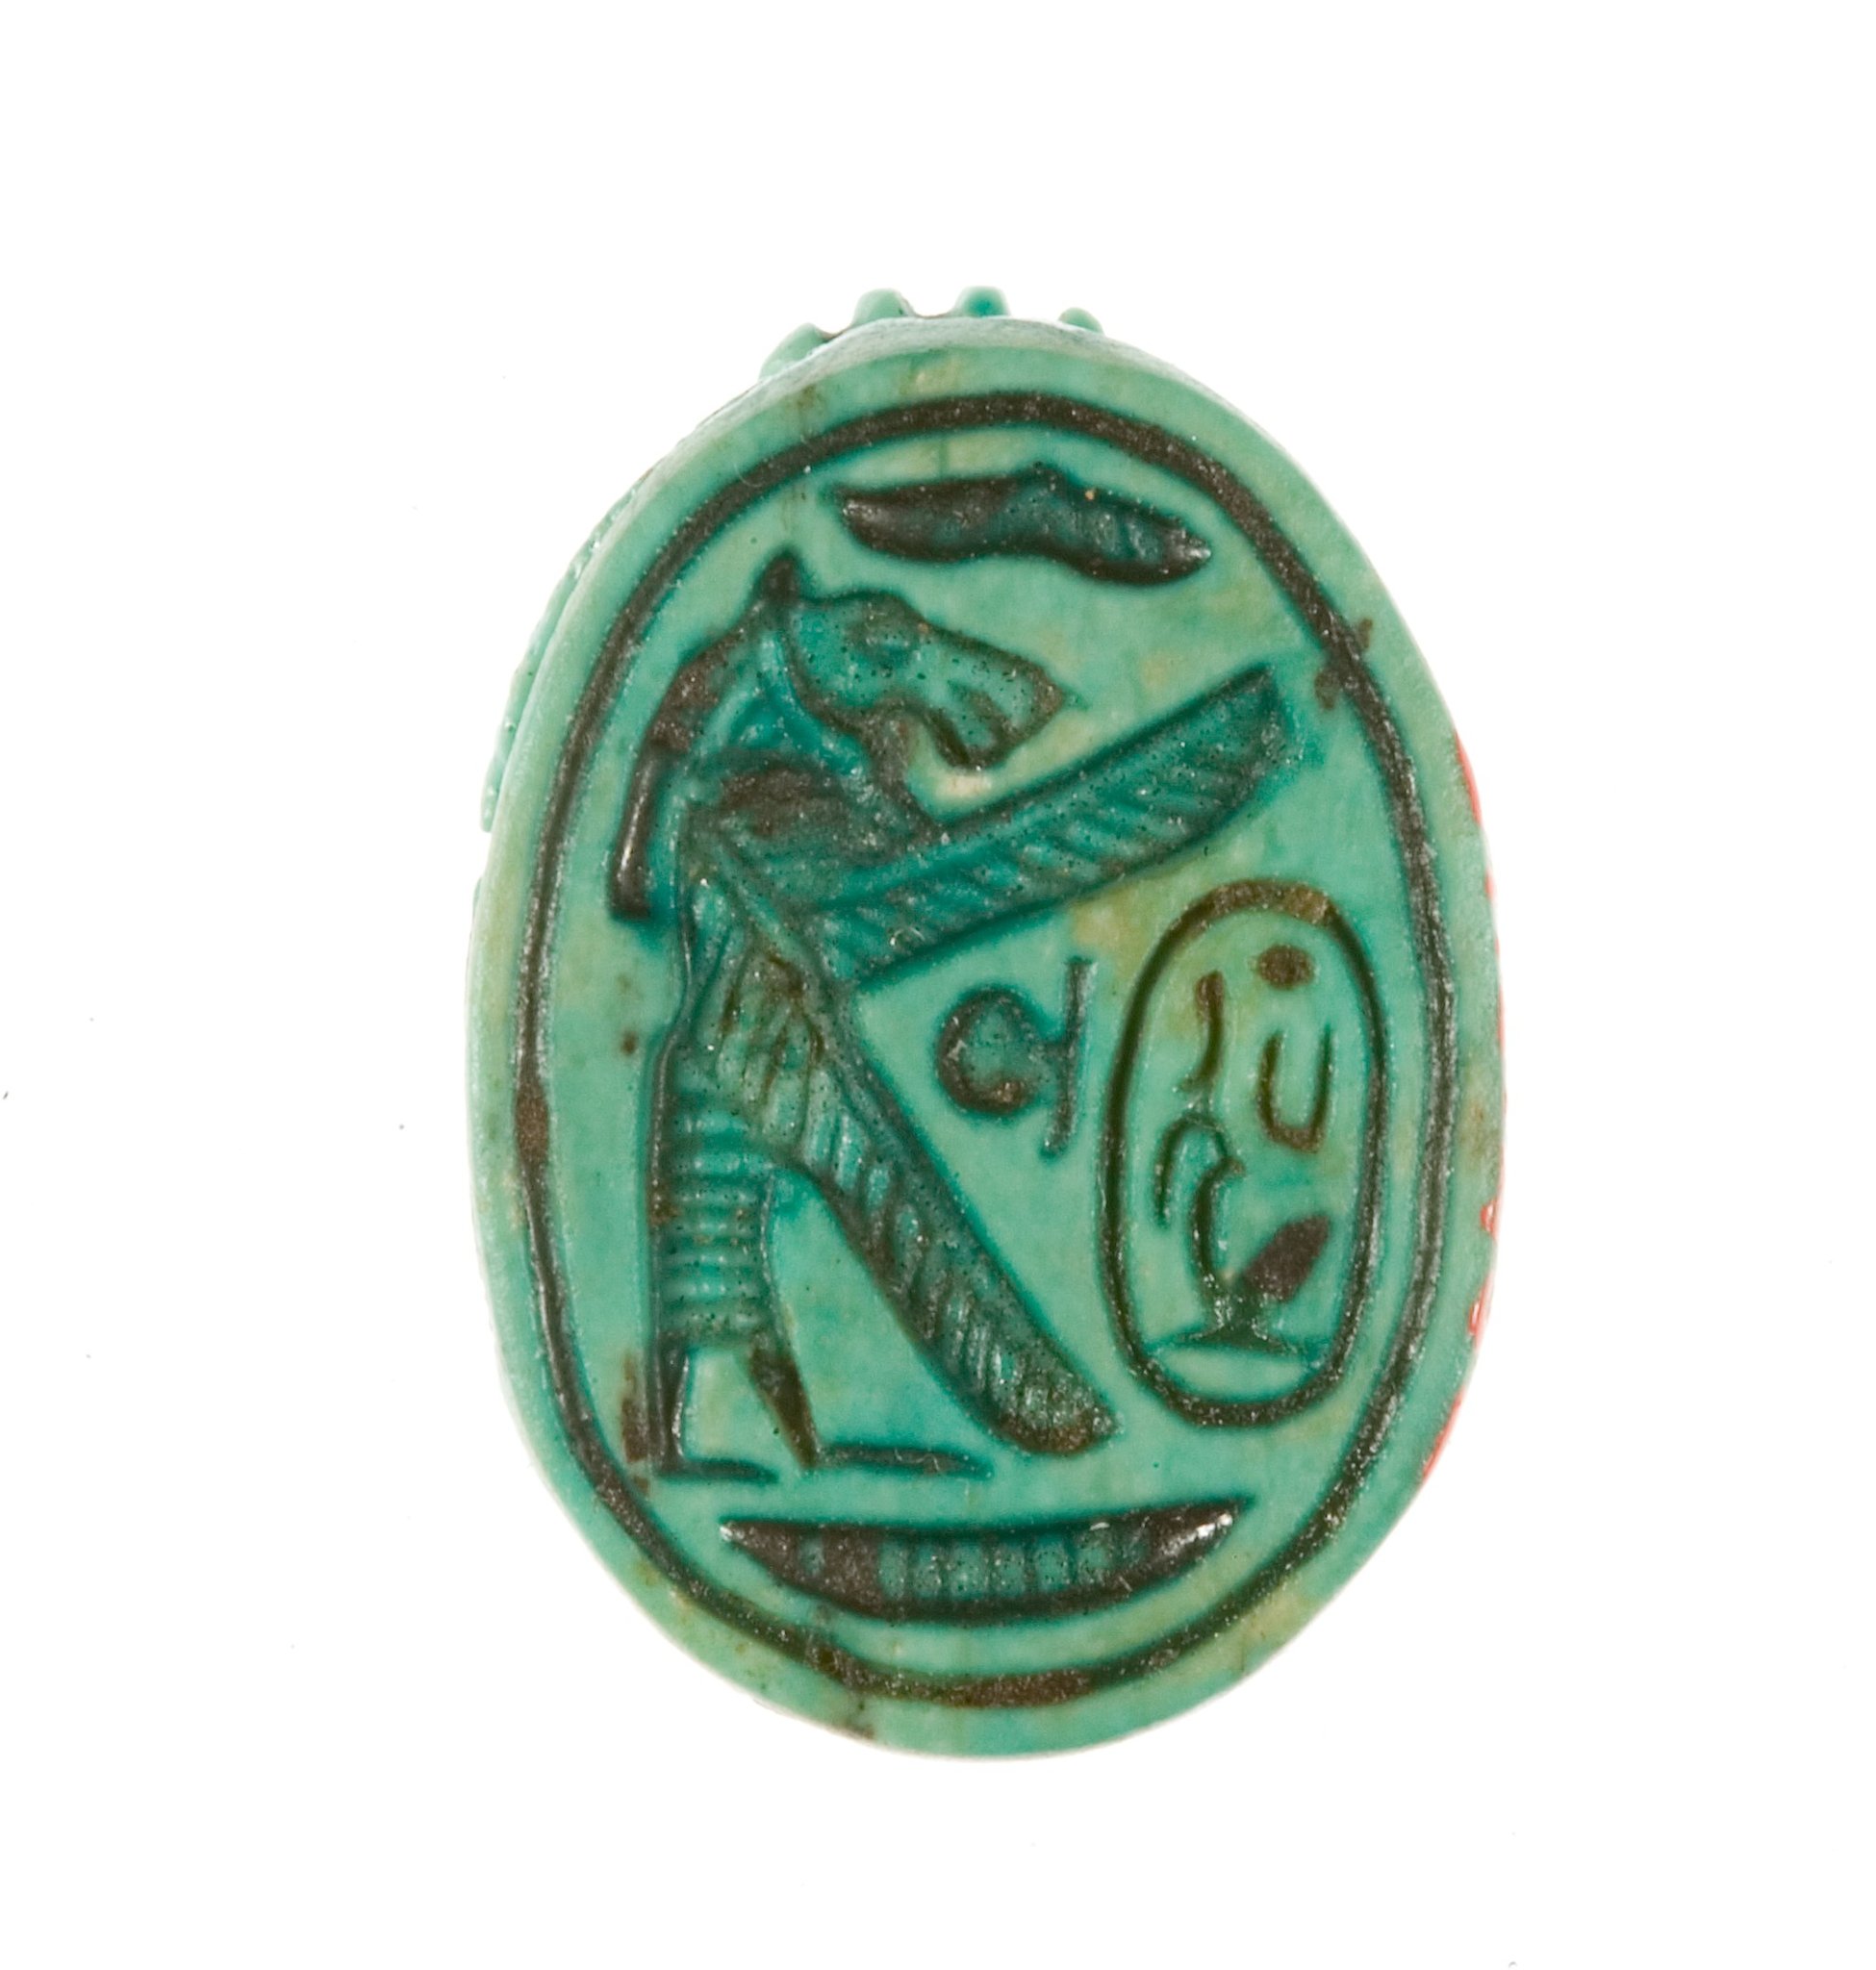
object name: scarab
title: Scarab with Lion-headed Goddess Protecting Maatkare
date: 1479-1458 BCE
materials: stone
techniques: glazing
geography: egypt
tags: scarabs,goddess